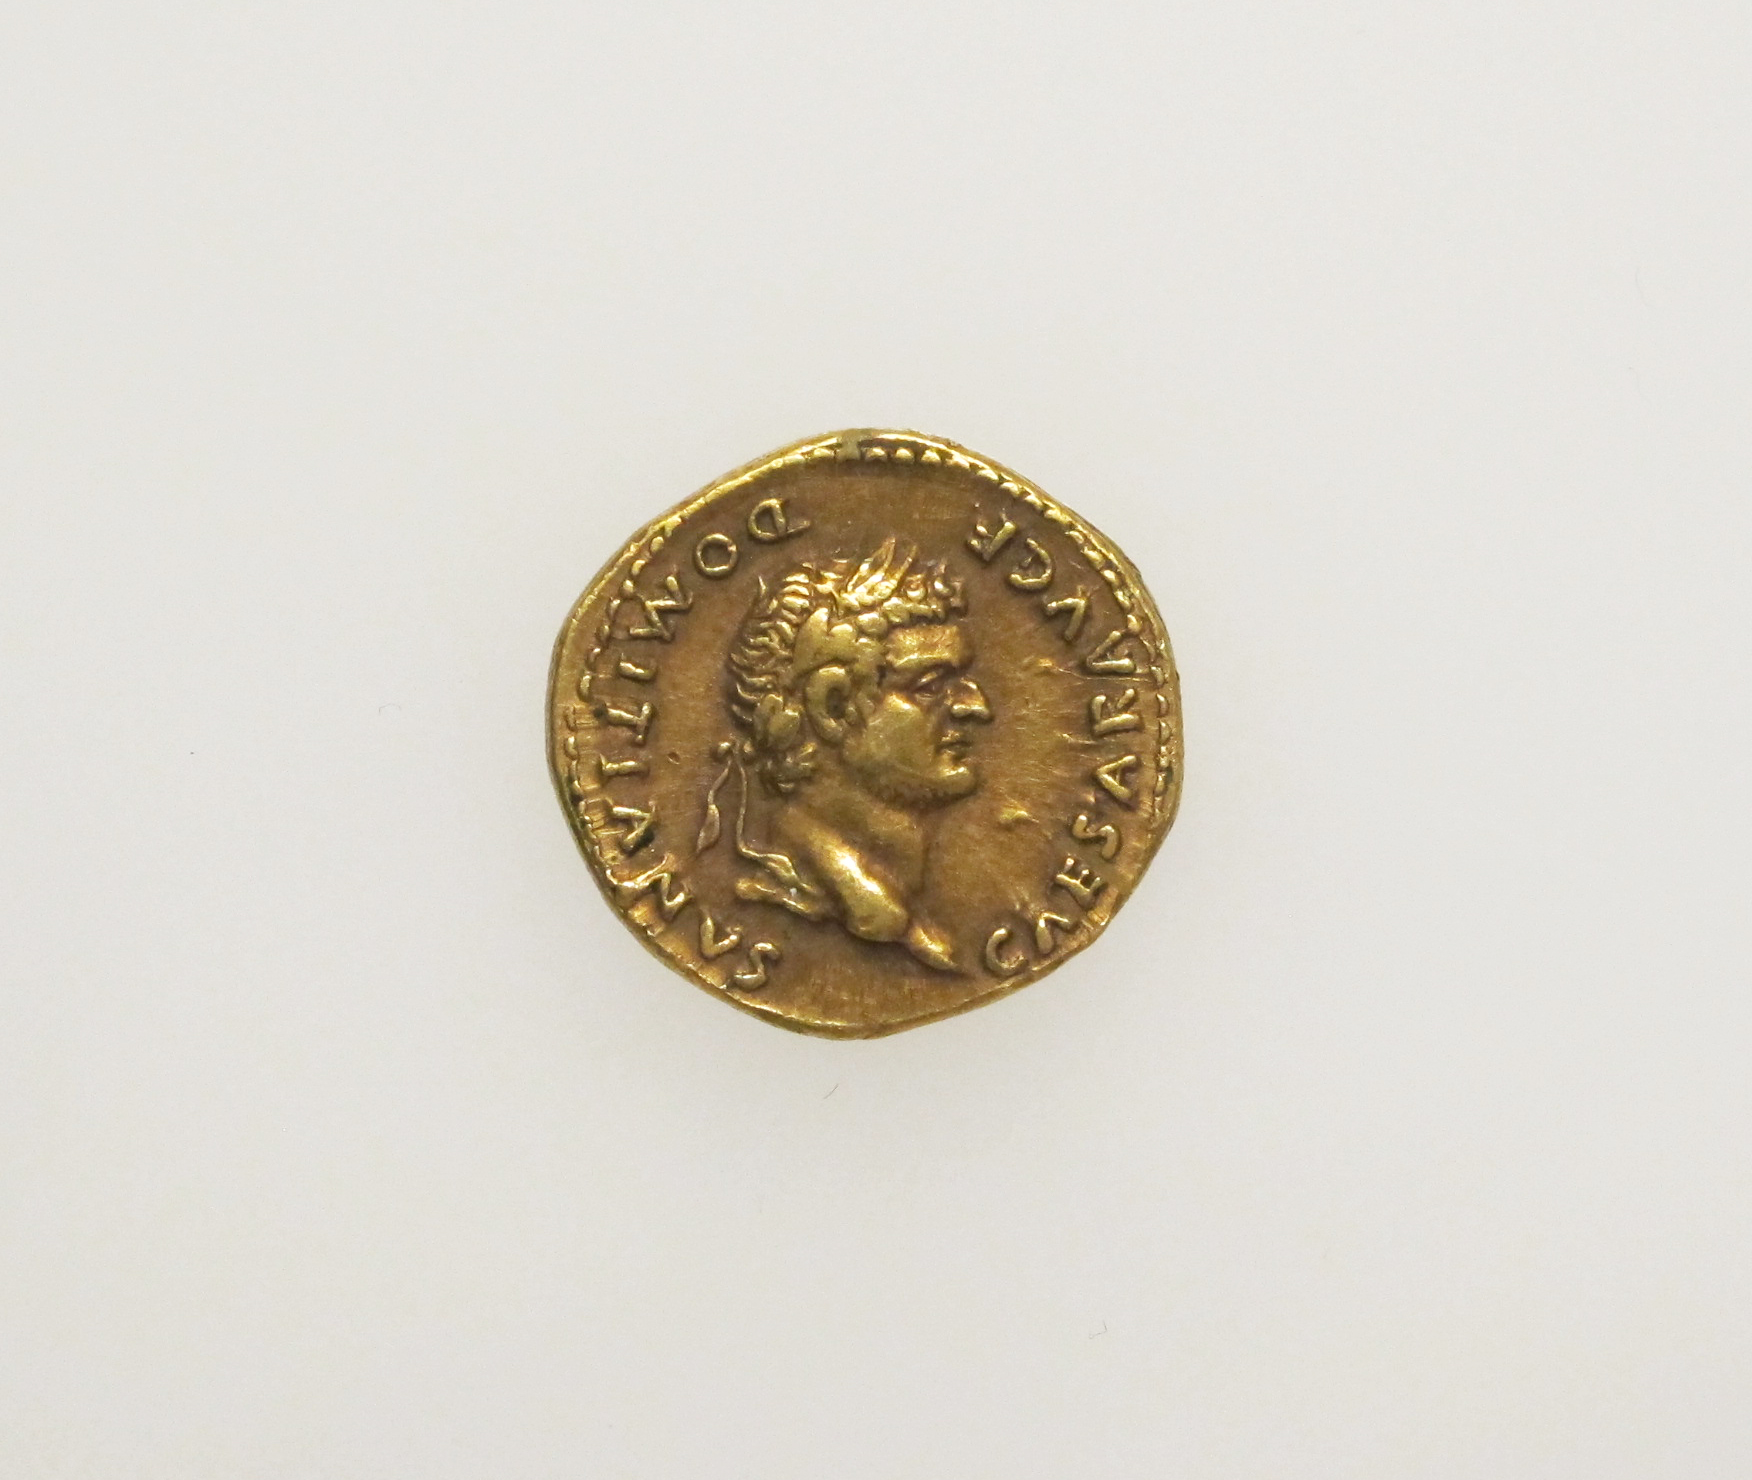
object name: aureus of vespasian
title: Gold aureus of Vespasian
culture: roman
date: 77-78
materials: gold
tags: men,profiles